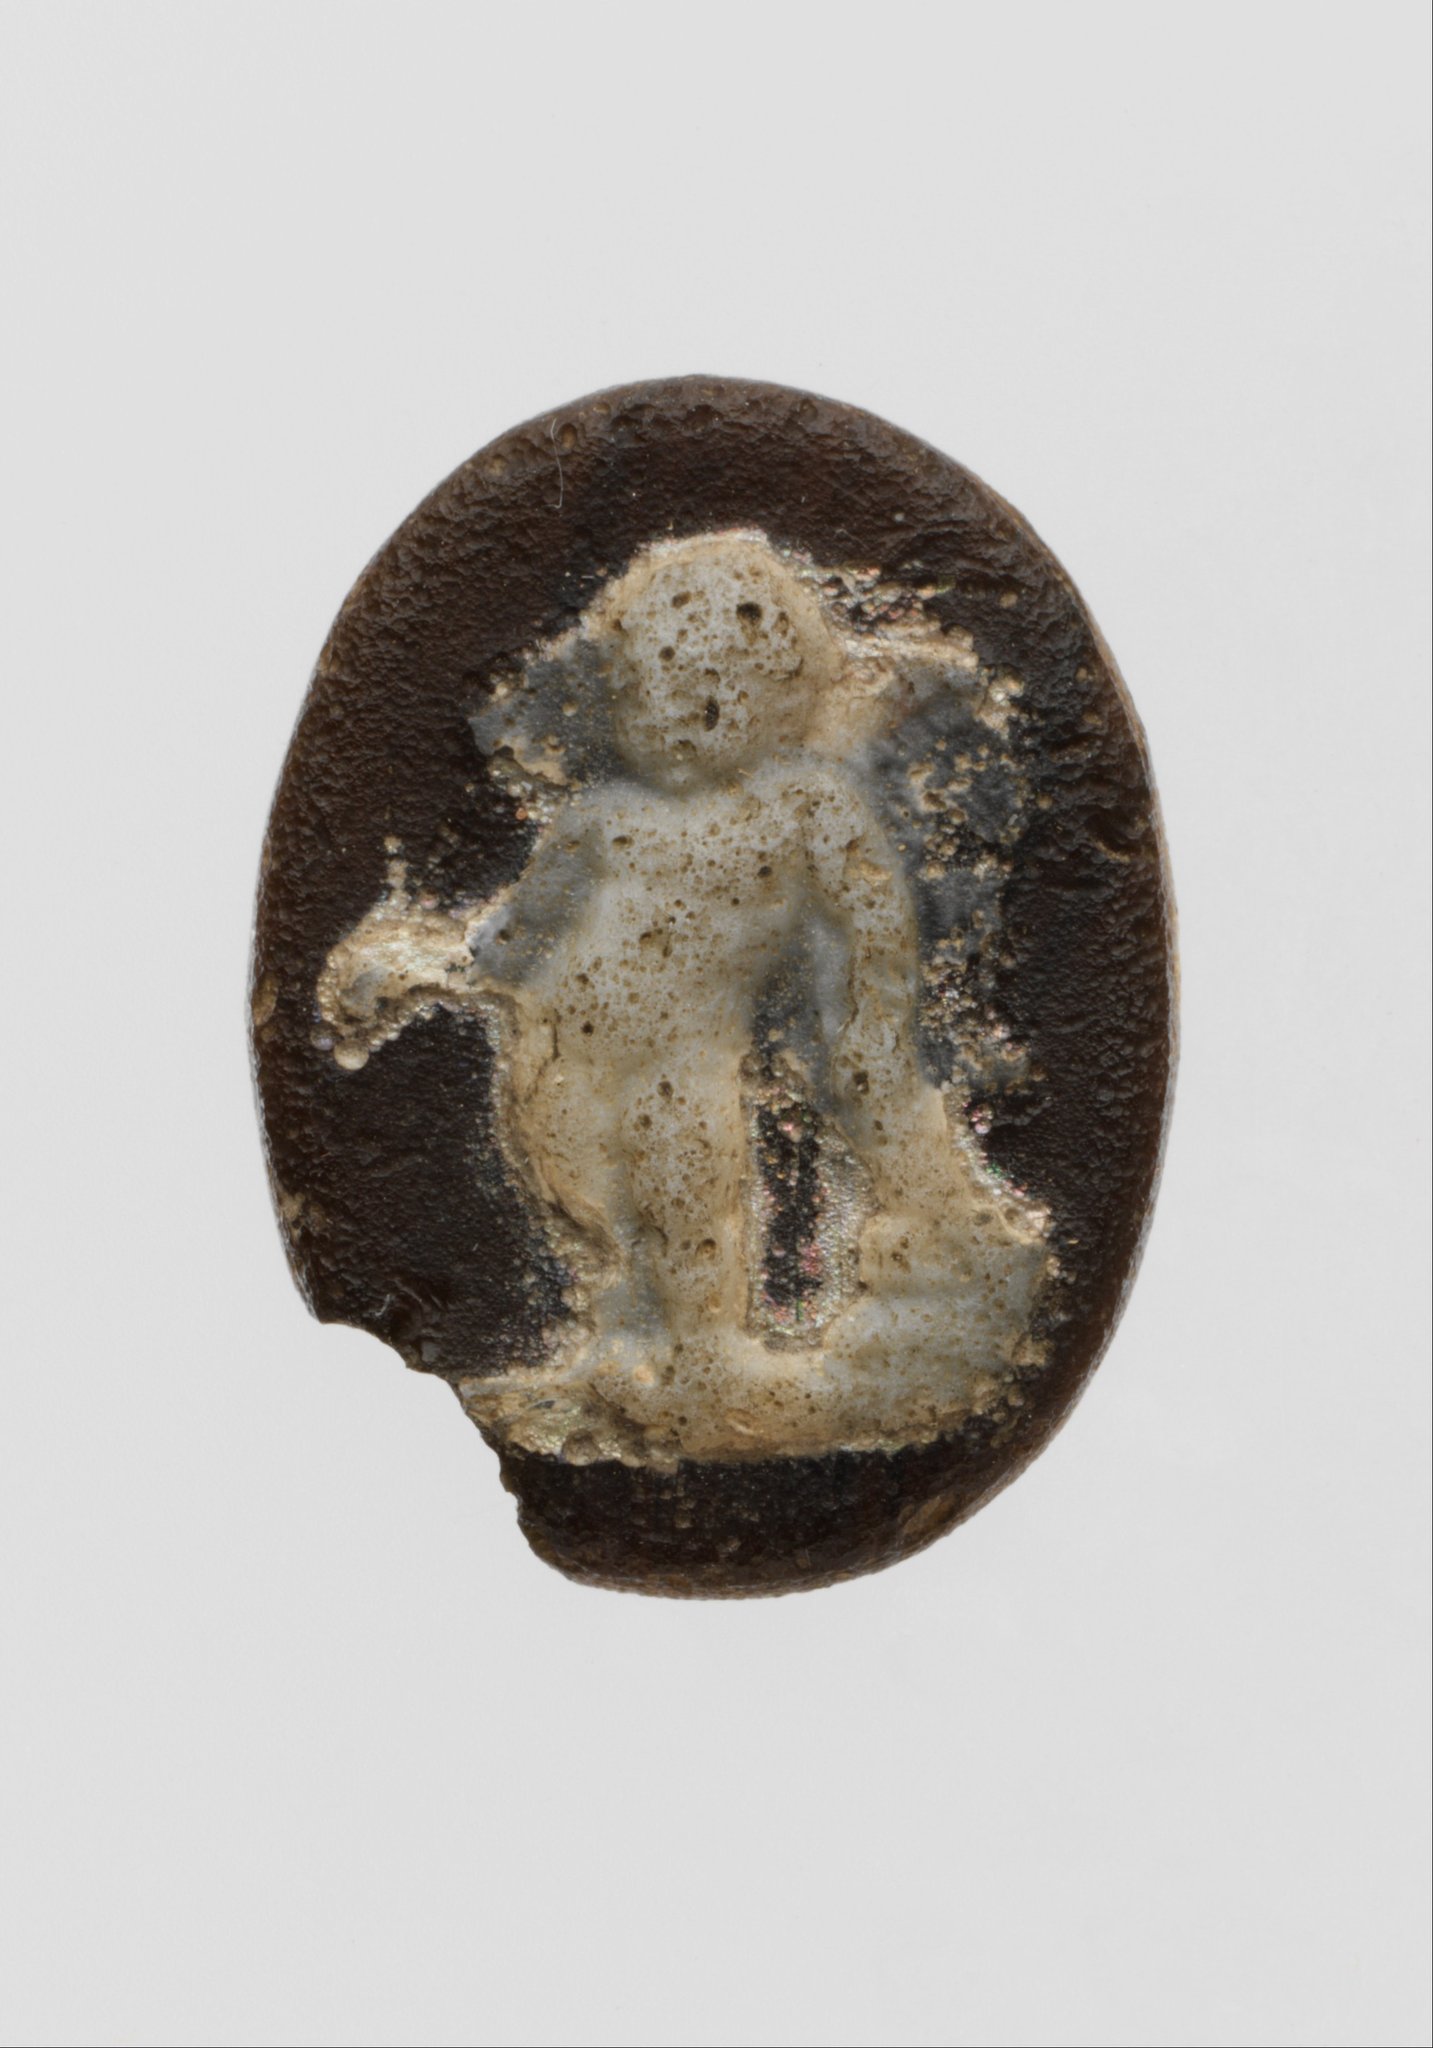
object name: cameo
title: Glass cameo: Eros holding a torch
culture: roman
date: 100 BCE-300 CE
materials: glass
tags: eros